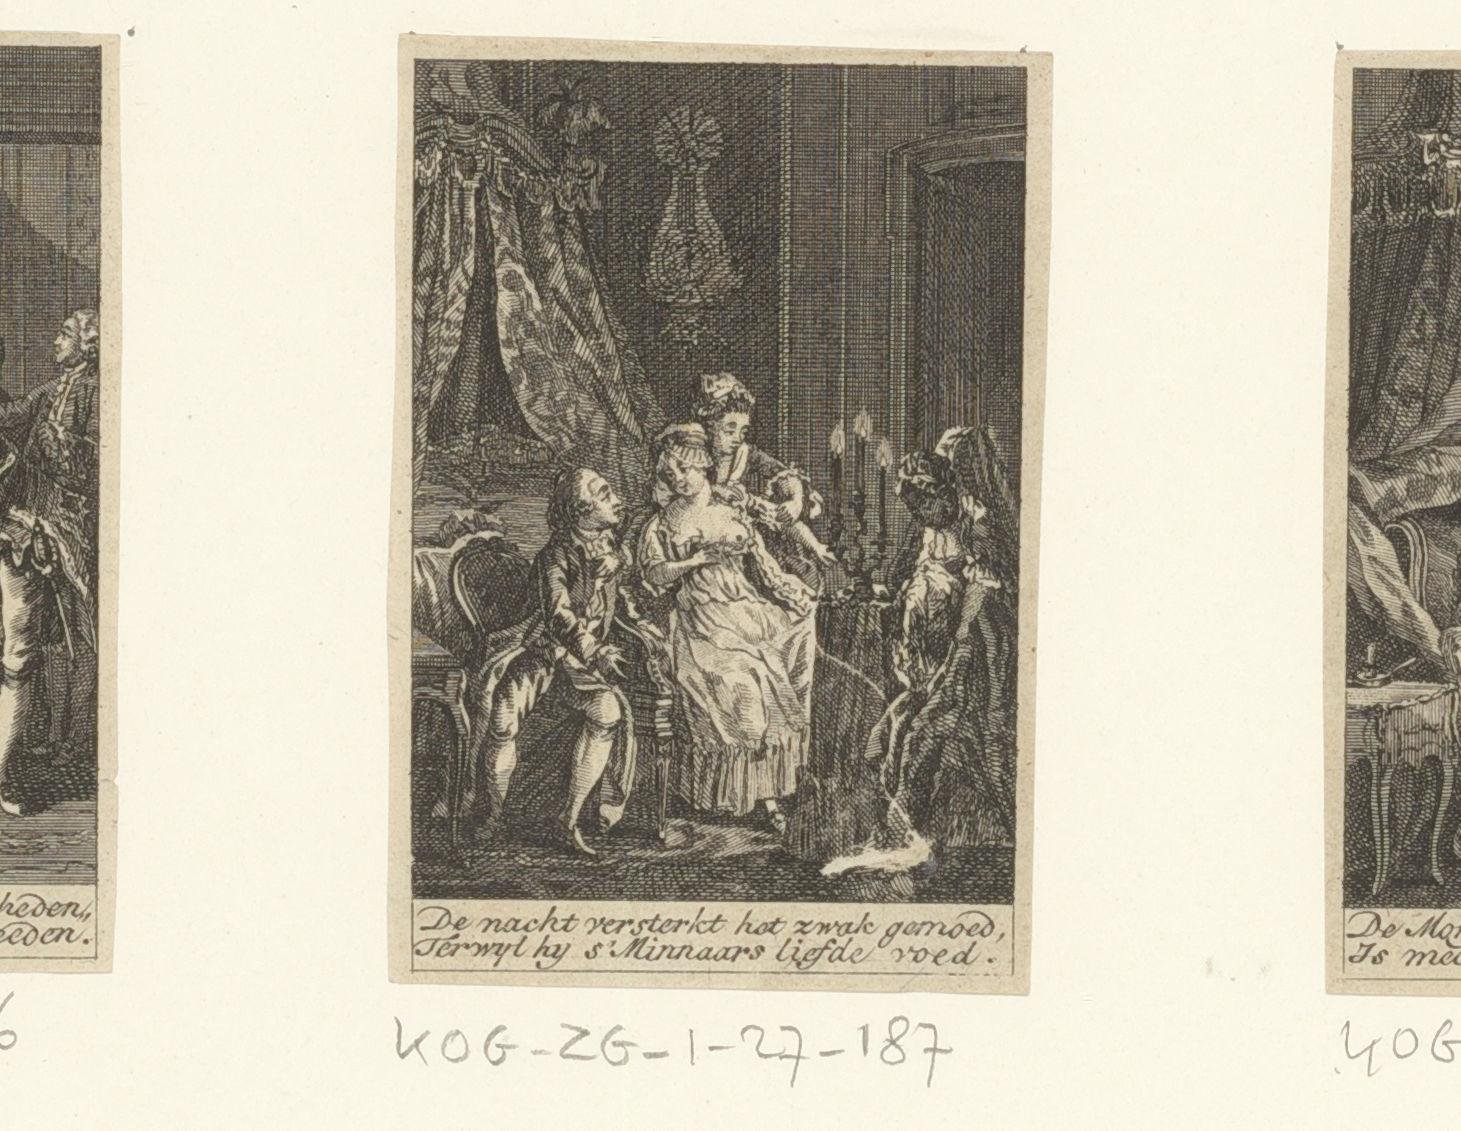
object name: print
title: Minnaar bij vrouw die zich klaar maakt voor bed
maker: Anonymous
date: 1725-1799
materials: paper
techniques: engraving, etching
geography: netherlands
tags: woman (showing herself) undressed, quasi-nude, undressing oneself, getting undressed, going to bed, couple of lovers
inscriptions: collector's mark, collector's mark: Lugt 1641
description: Gebruikt als illustratie in een onbekende almanak.